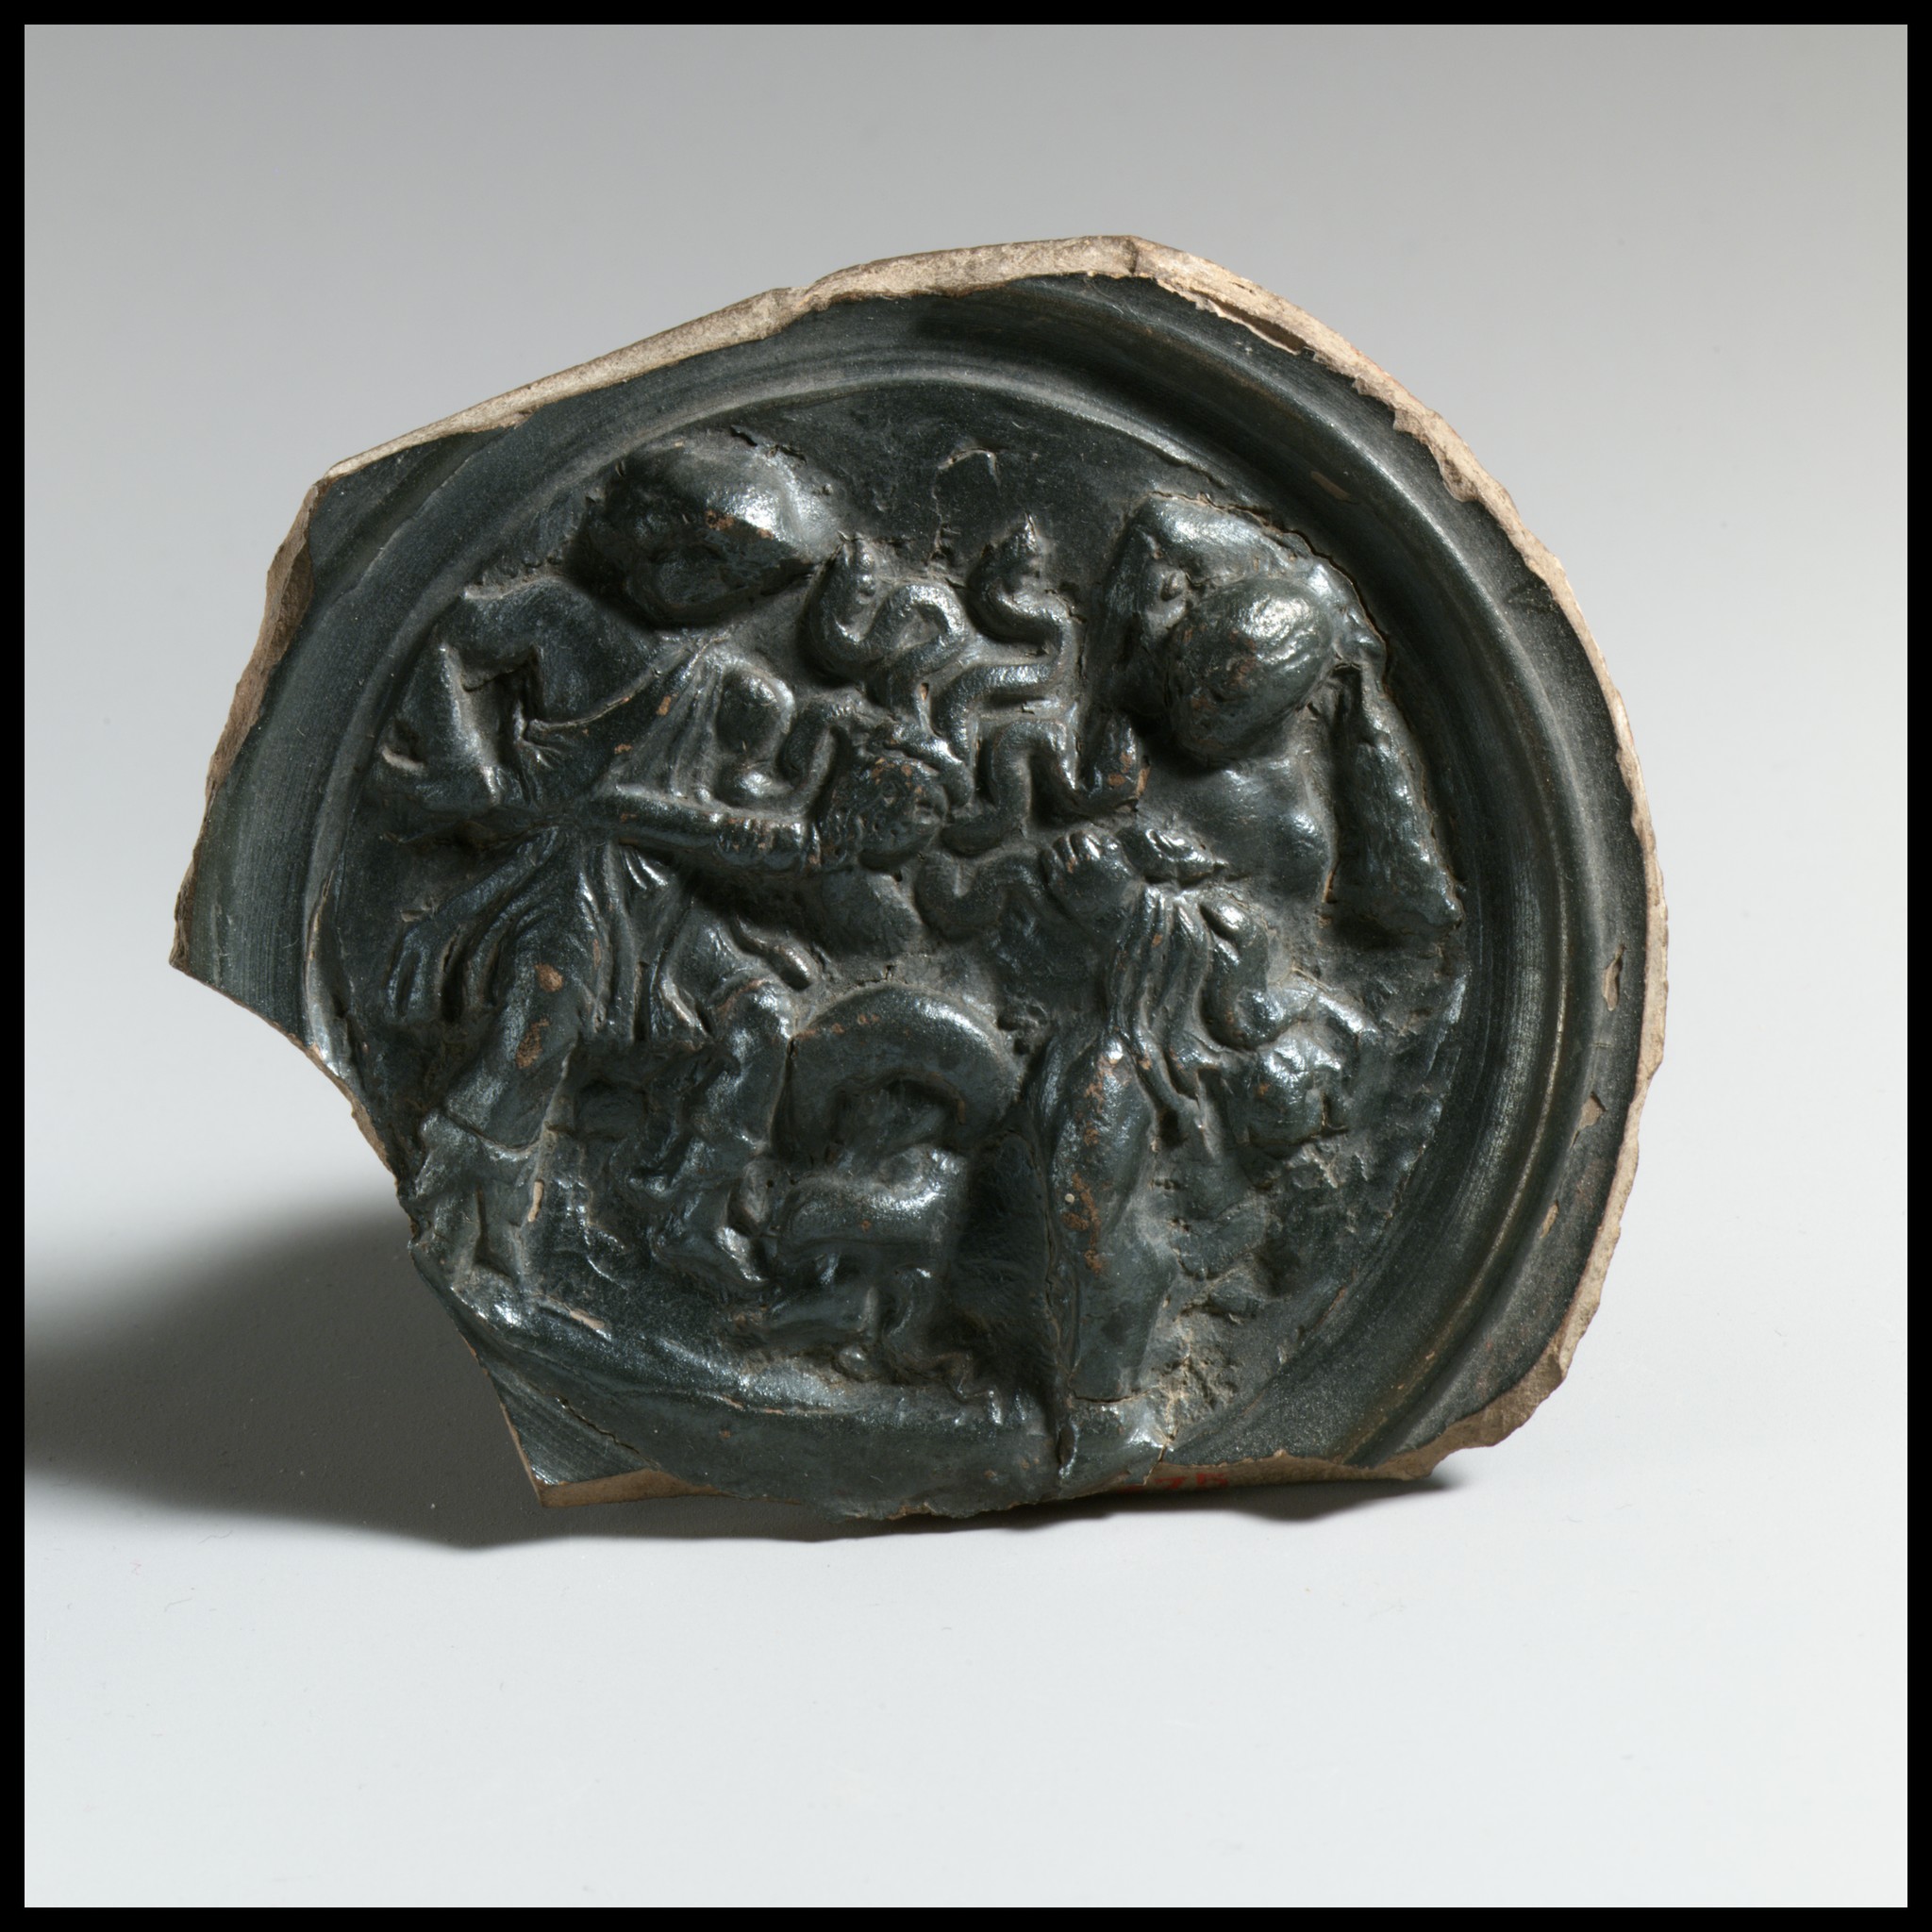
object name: phiale, fragmentary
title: Terracotta tondo from a phiale (libation bowl)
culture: greek, calenian or campanian or south italian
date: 334-201 BCE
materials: terracotta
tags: herakles